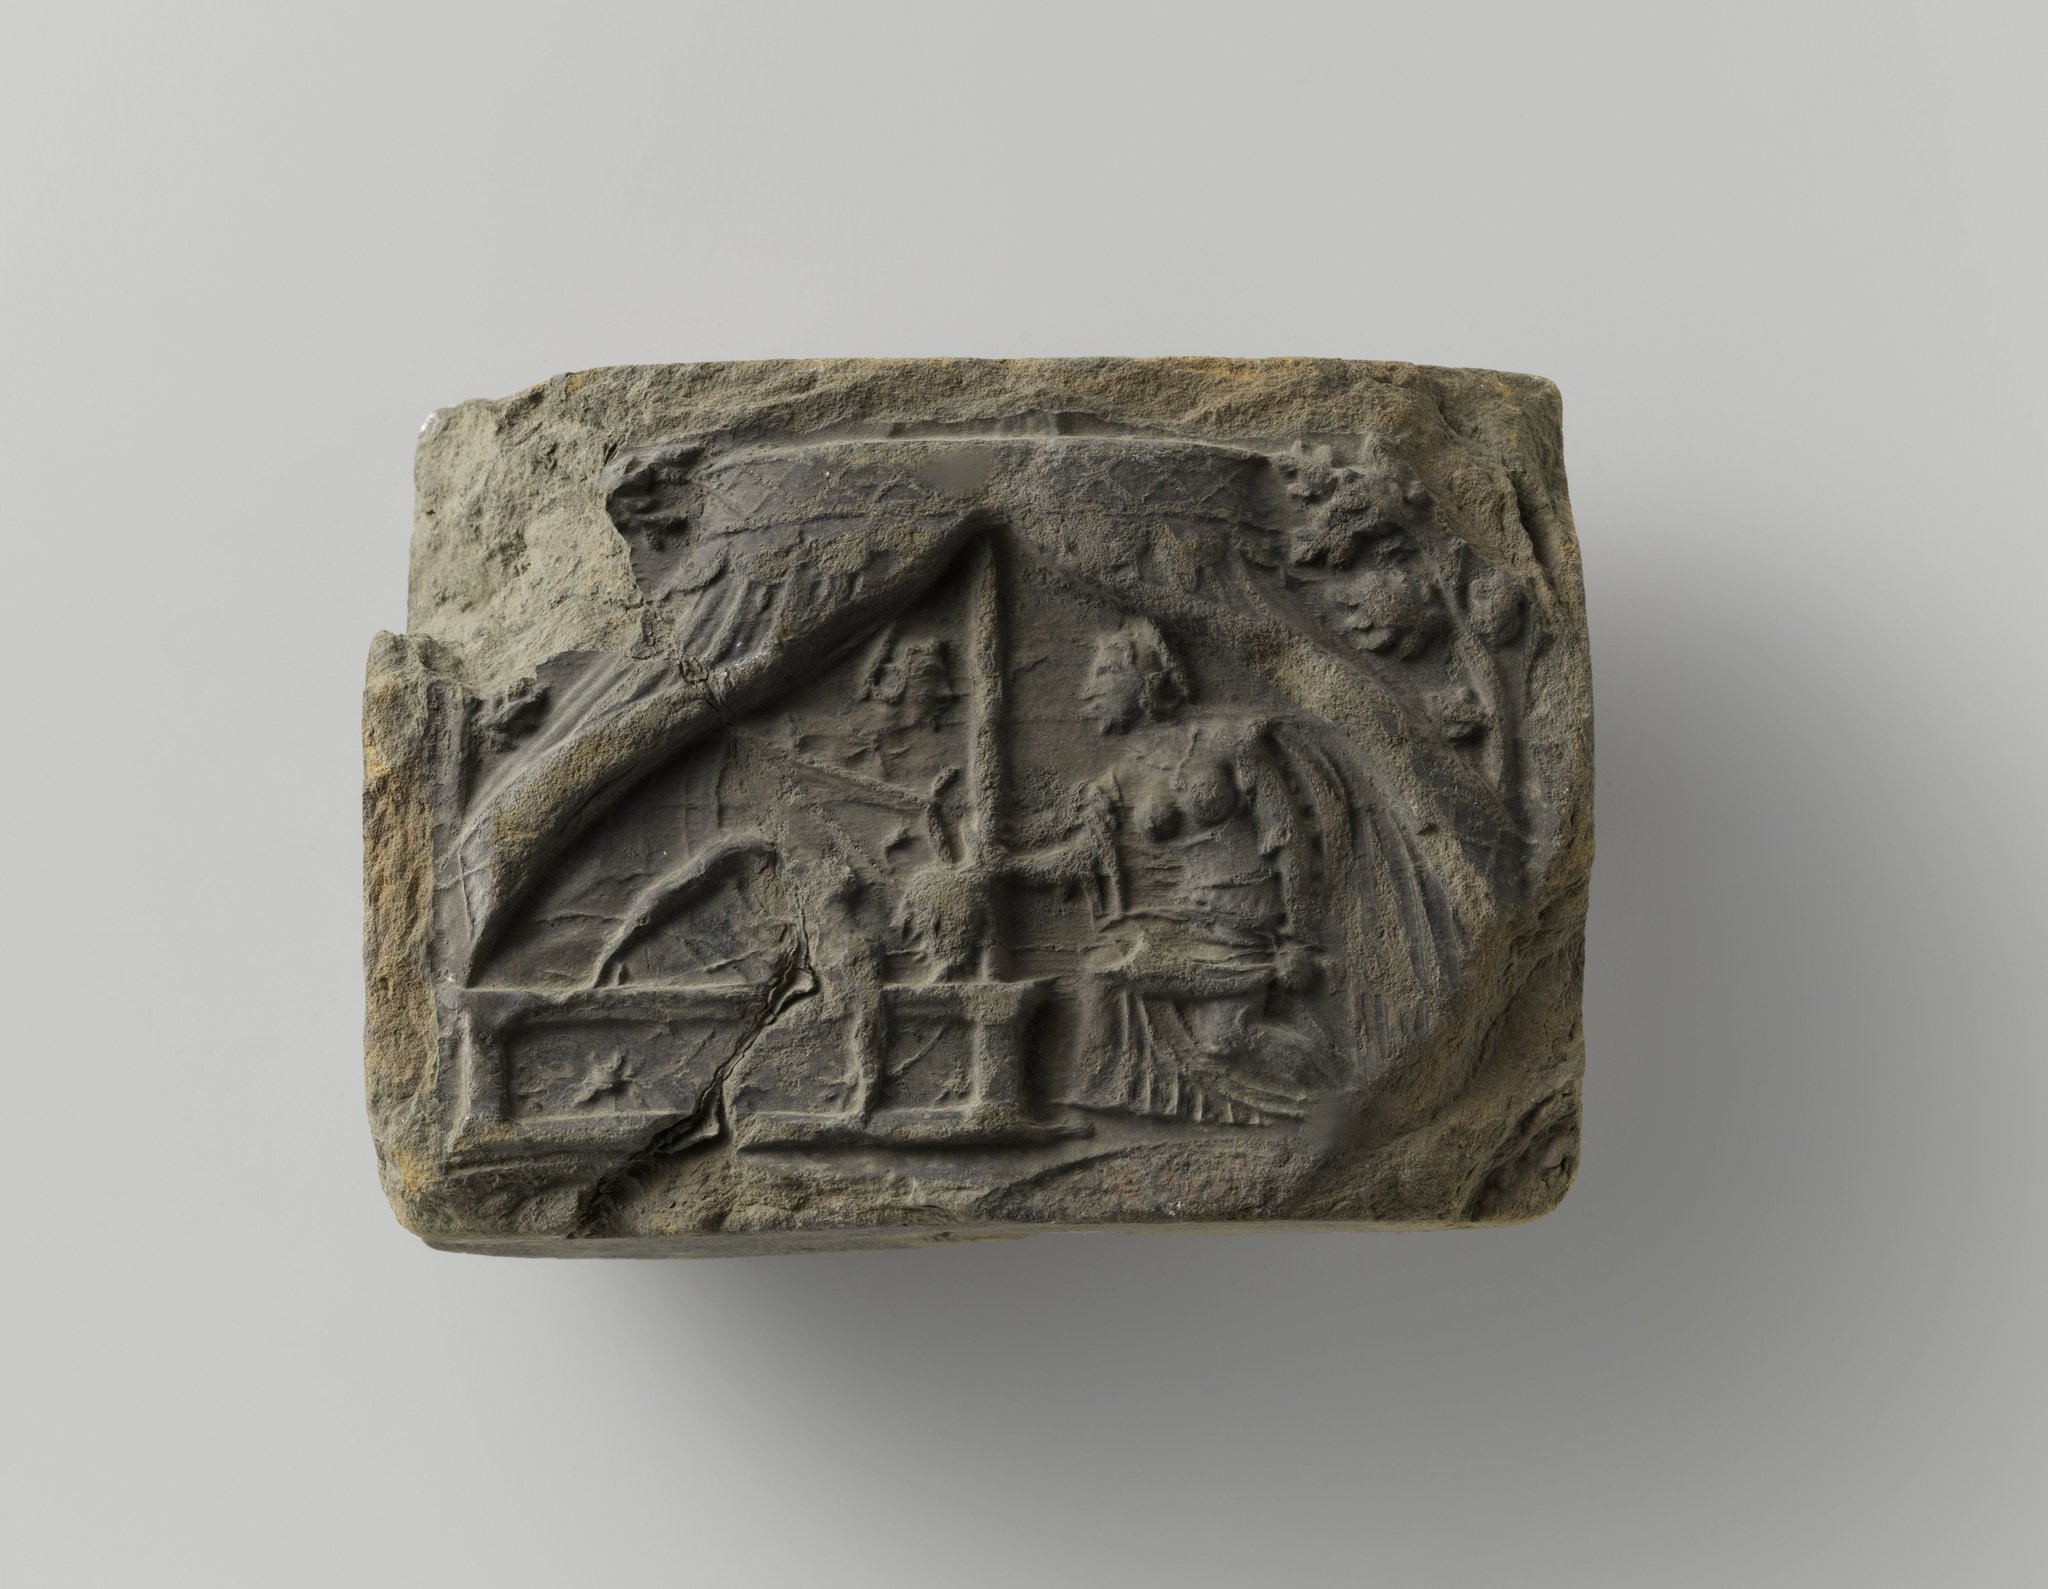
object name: hearthstone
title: Haardsteen met een voorstelling van Judith, die op het punt staat de slapende Holofernes in diens tent te onthoofden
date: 1525-1575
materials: earthenware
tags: holofernes beheaded by judith with his own sword; the maidservant may be keeping watch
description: Haardsteen met een voorstelling van Judith, die op het punt staat de slapende Holofernes in diens tent te onthoofden.